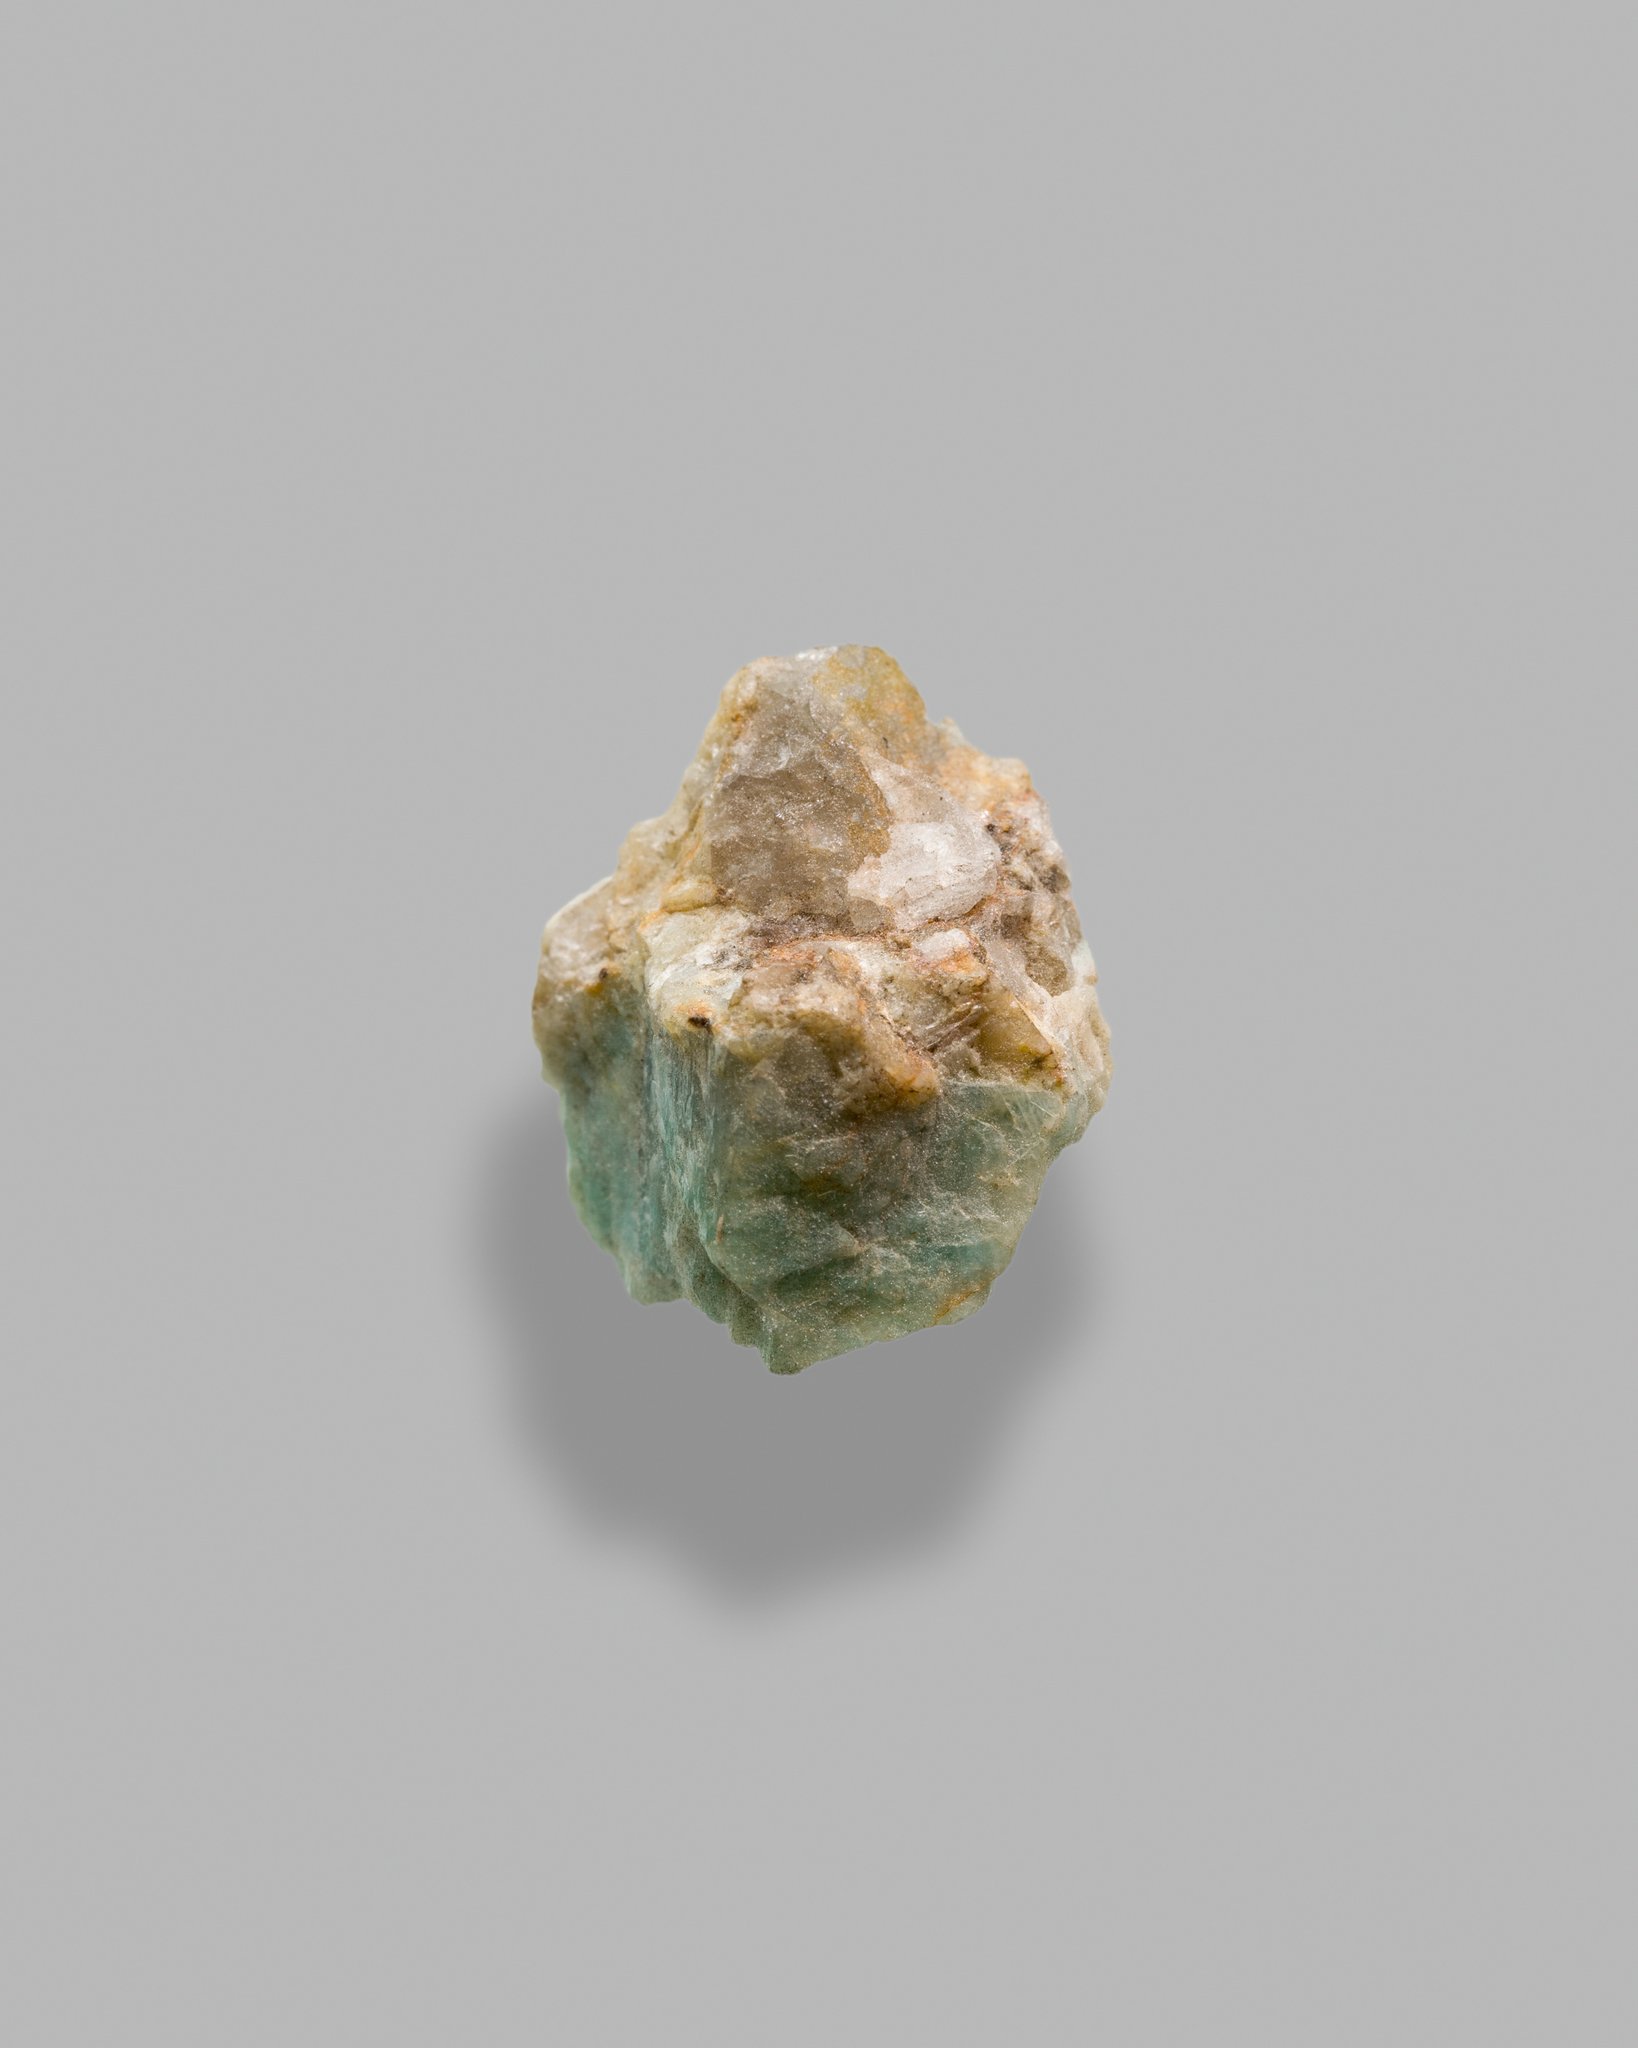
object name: fragment, feldspar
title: Lump of Green Feldspar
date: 1153-1147 BCE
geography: egypt